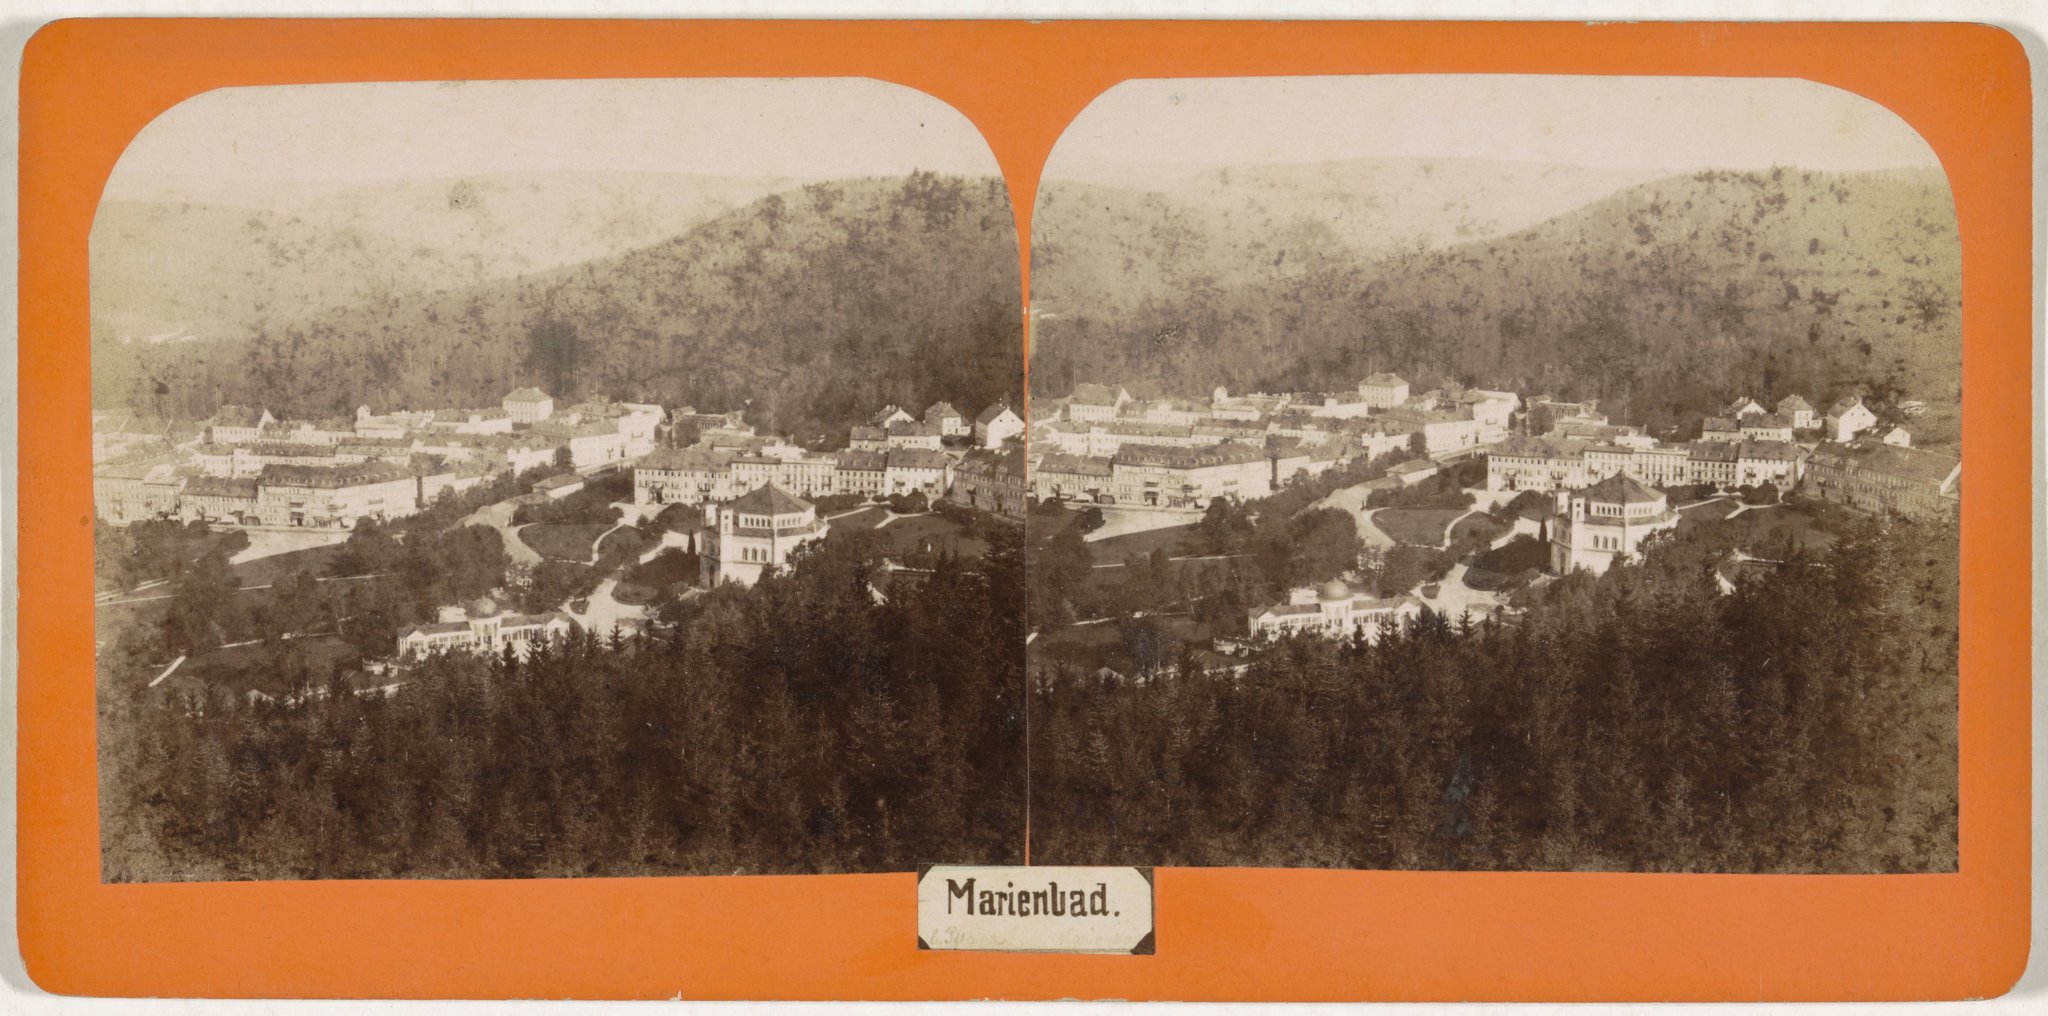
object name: stereograph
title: Marienbad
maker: ernst pflanz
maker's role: painter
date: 1865-1885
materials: cardboard, celluloid, paper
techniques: albumen print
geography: marienbad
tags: city-view in general; 'veduta', marienbad